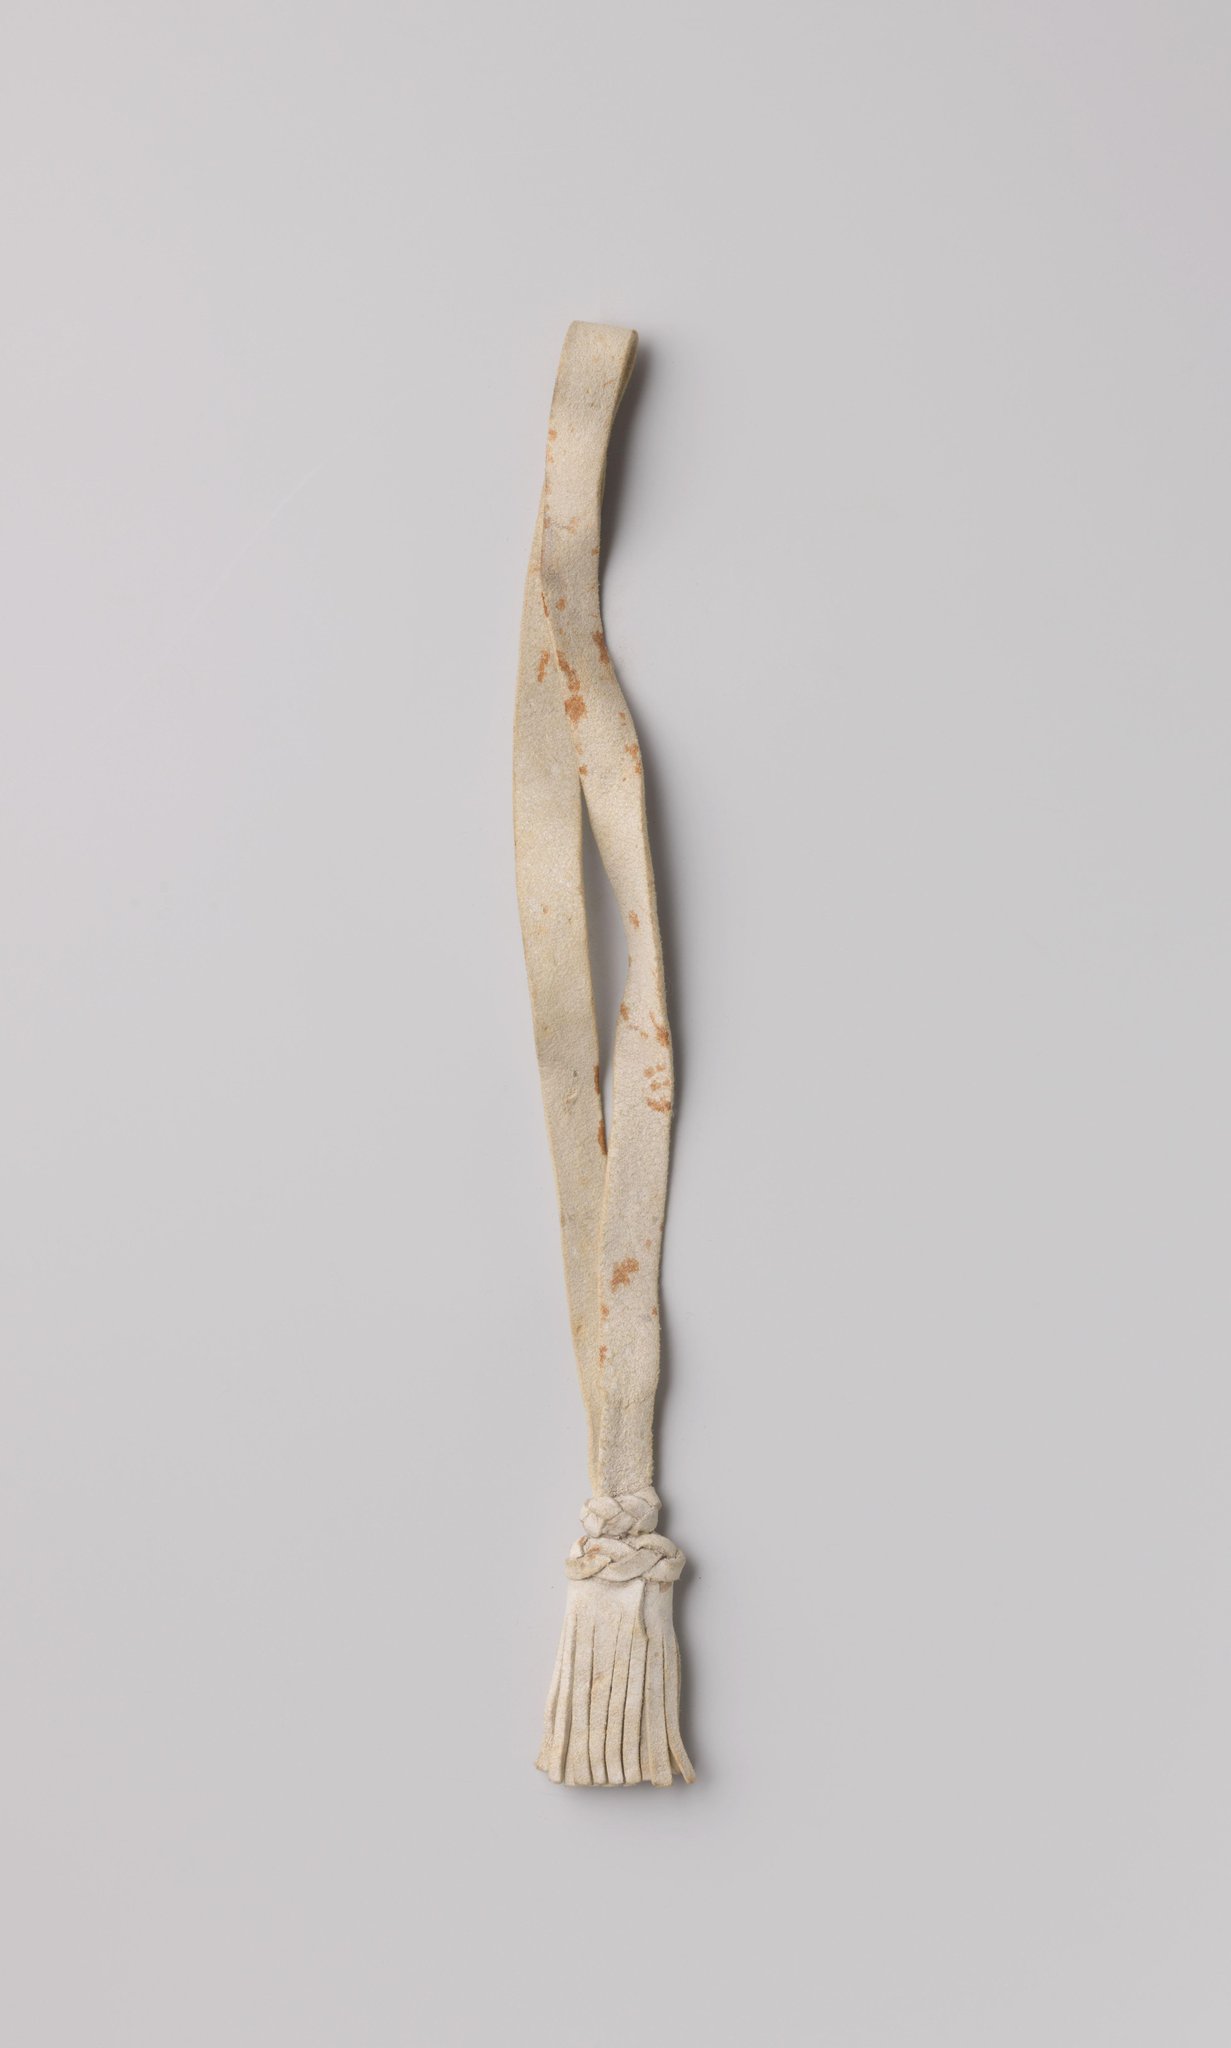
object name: porte epée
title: Dragon voor sabel beredenen, vermoedelijk voor schutters te paard van Amsterdam 1830-1839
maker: Anonymous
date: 1830-1839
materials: leather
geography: netherlands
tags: amsterdam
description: Platte leren lus, gewit met pijpaarde. Bevestigd aan een platte gewitte leren kwast met vlechtwerk, waarboven een plat leren knoop.